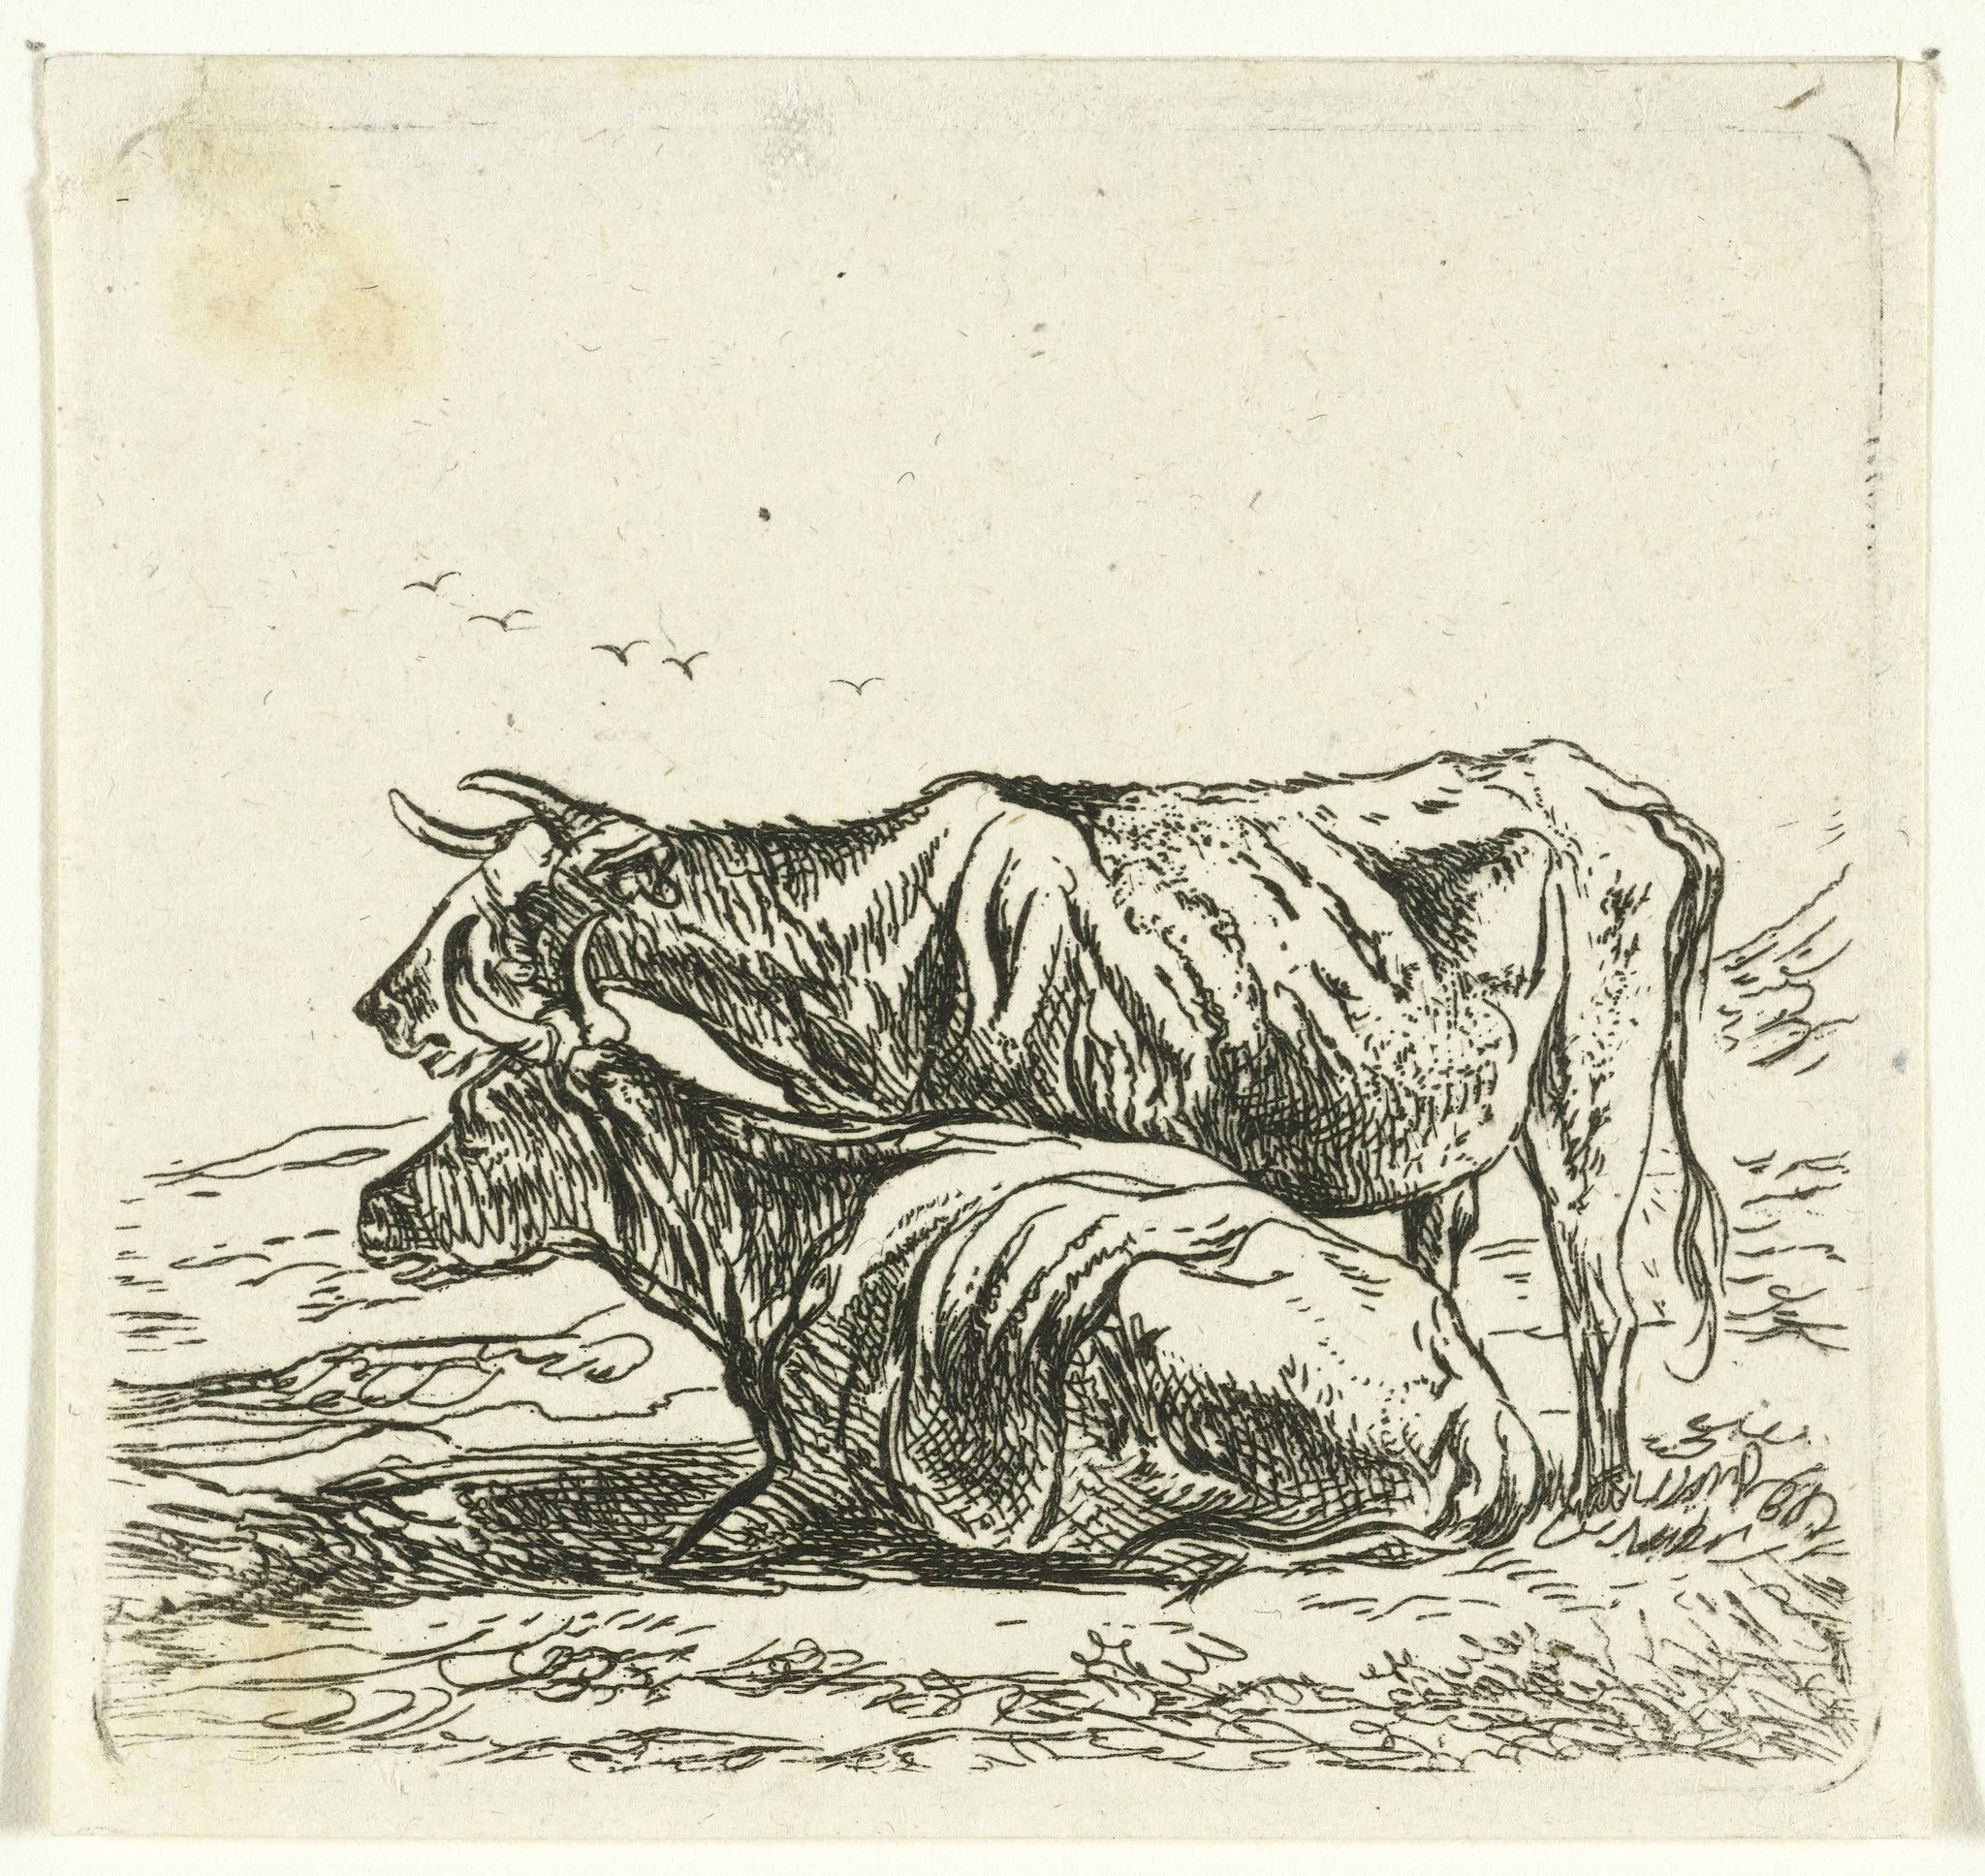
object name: print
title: Koeien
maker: Anonymous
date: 1630-1691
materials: paper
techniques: etching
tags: cow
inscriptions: collector's mark: Lugt 2228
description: Kopie naar prent uit serie van zes prenten met koeien van Aelbert Cuyp.